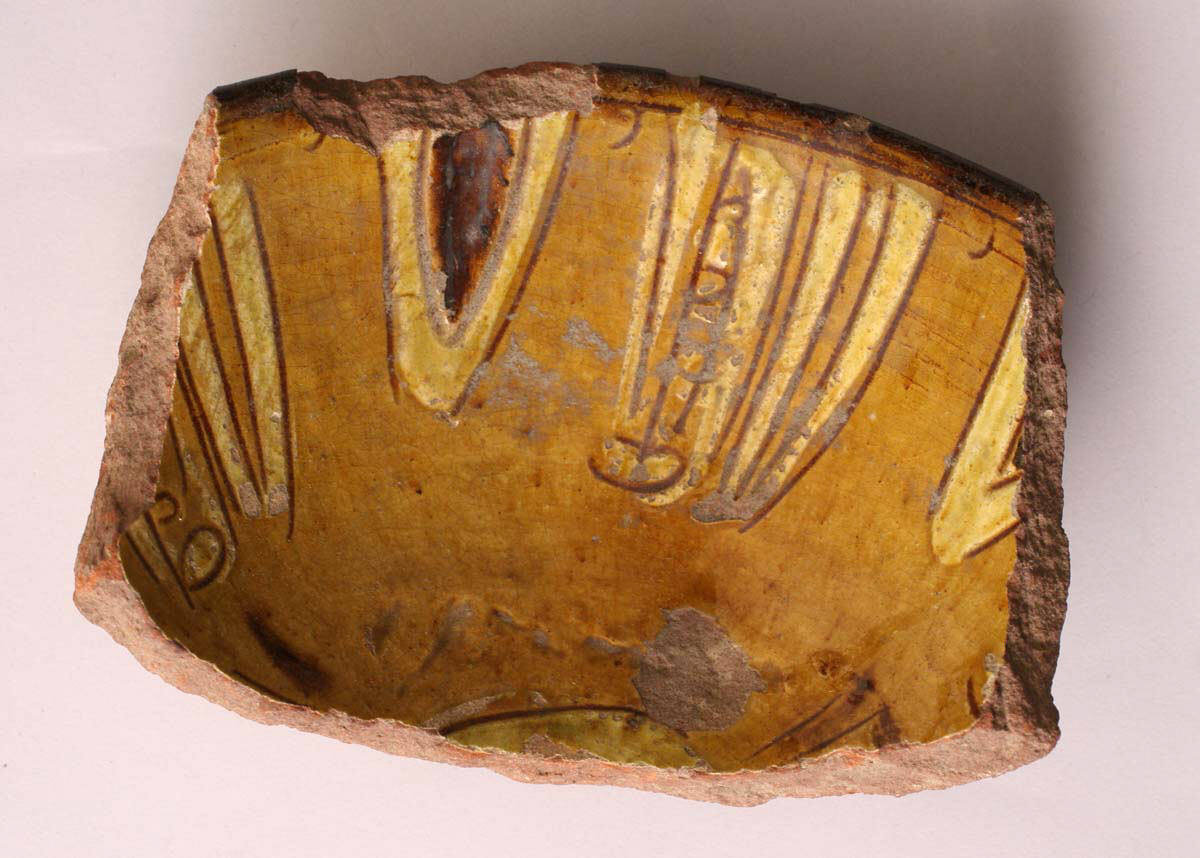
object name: fragment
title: Ceramic Fragment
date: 1301-1500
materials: earthenware, glaze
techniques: coloring, incising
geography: egypt